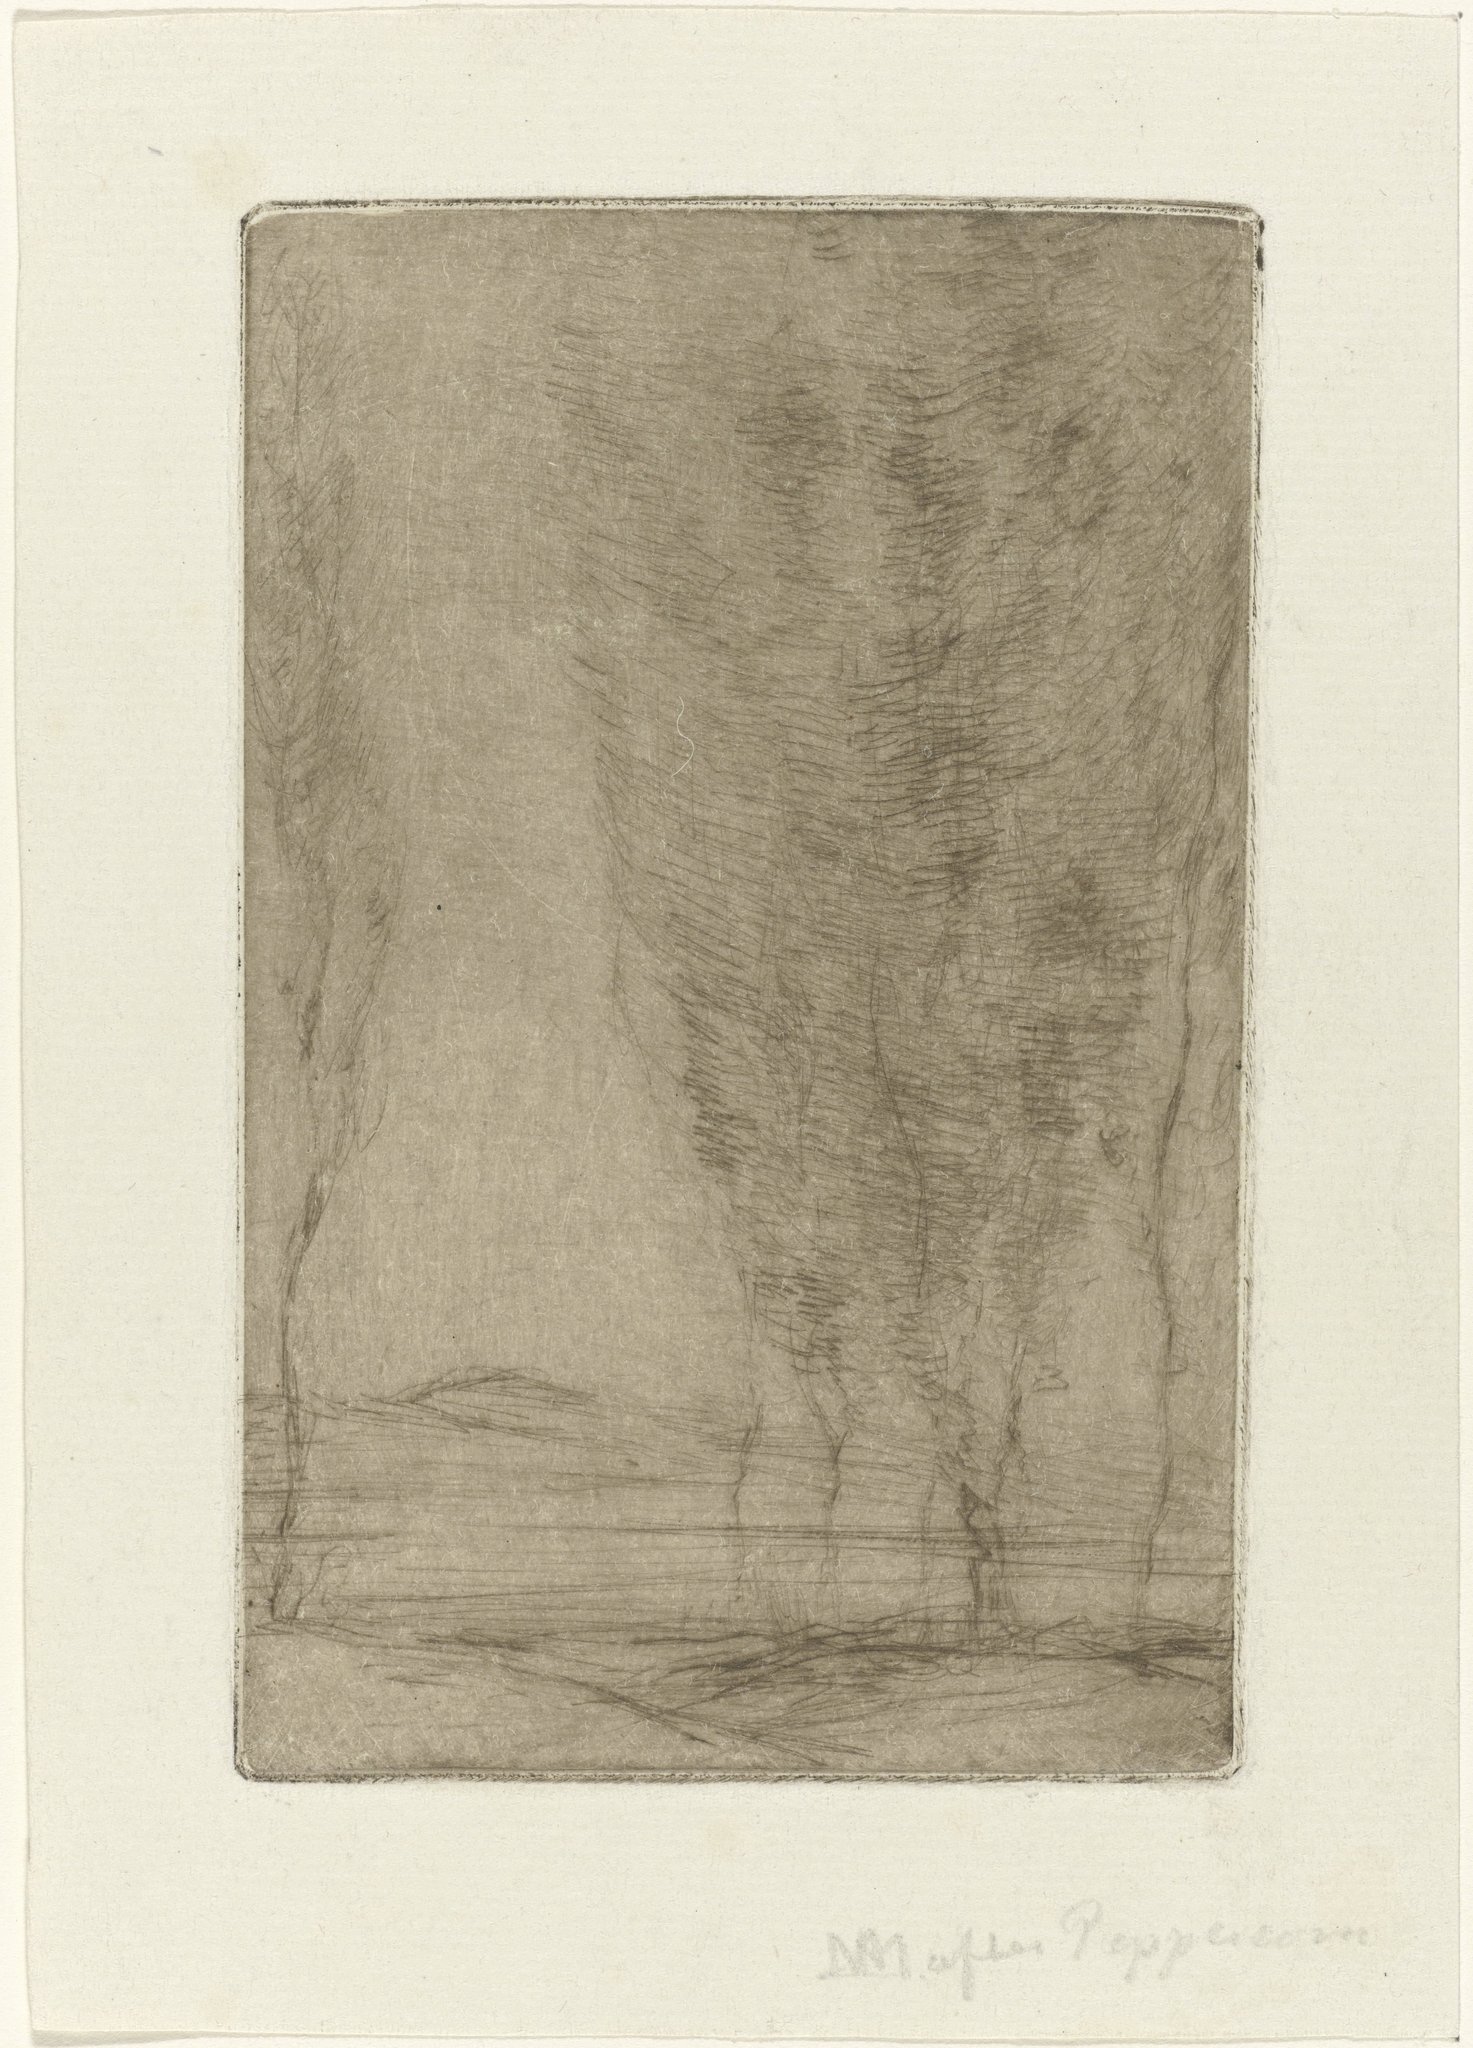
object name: print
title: Landscape with a Low Horizon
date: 1880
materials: paper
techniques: etching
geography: london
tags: trees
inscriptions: collector's mark: Lugt 2233, inscription: ‘MM after Peppercorn’